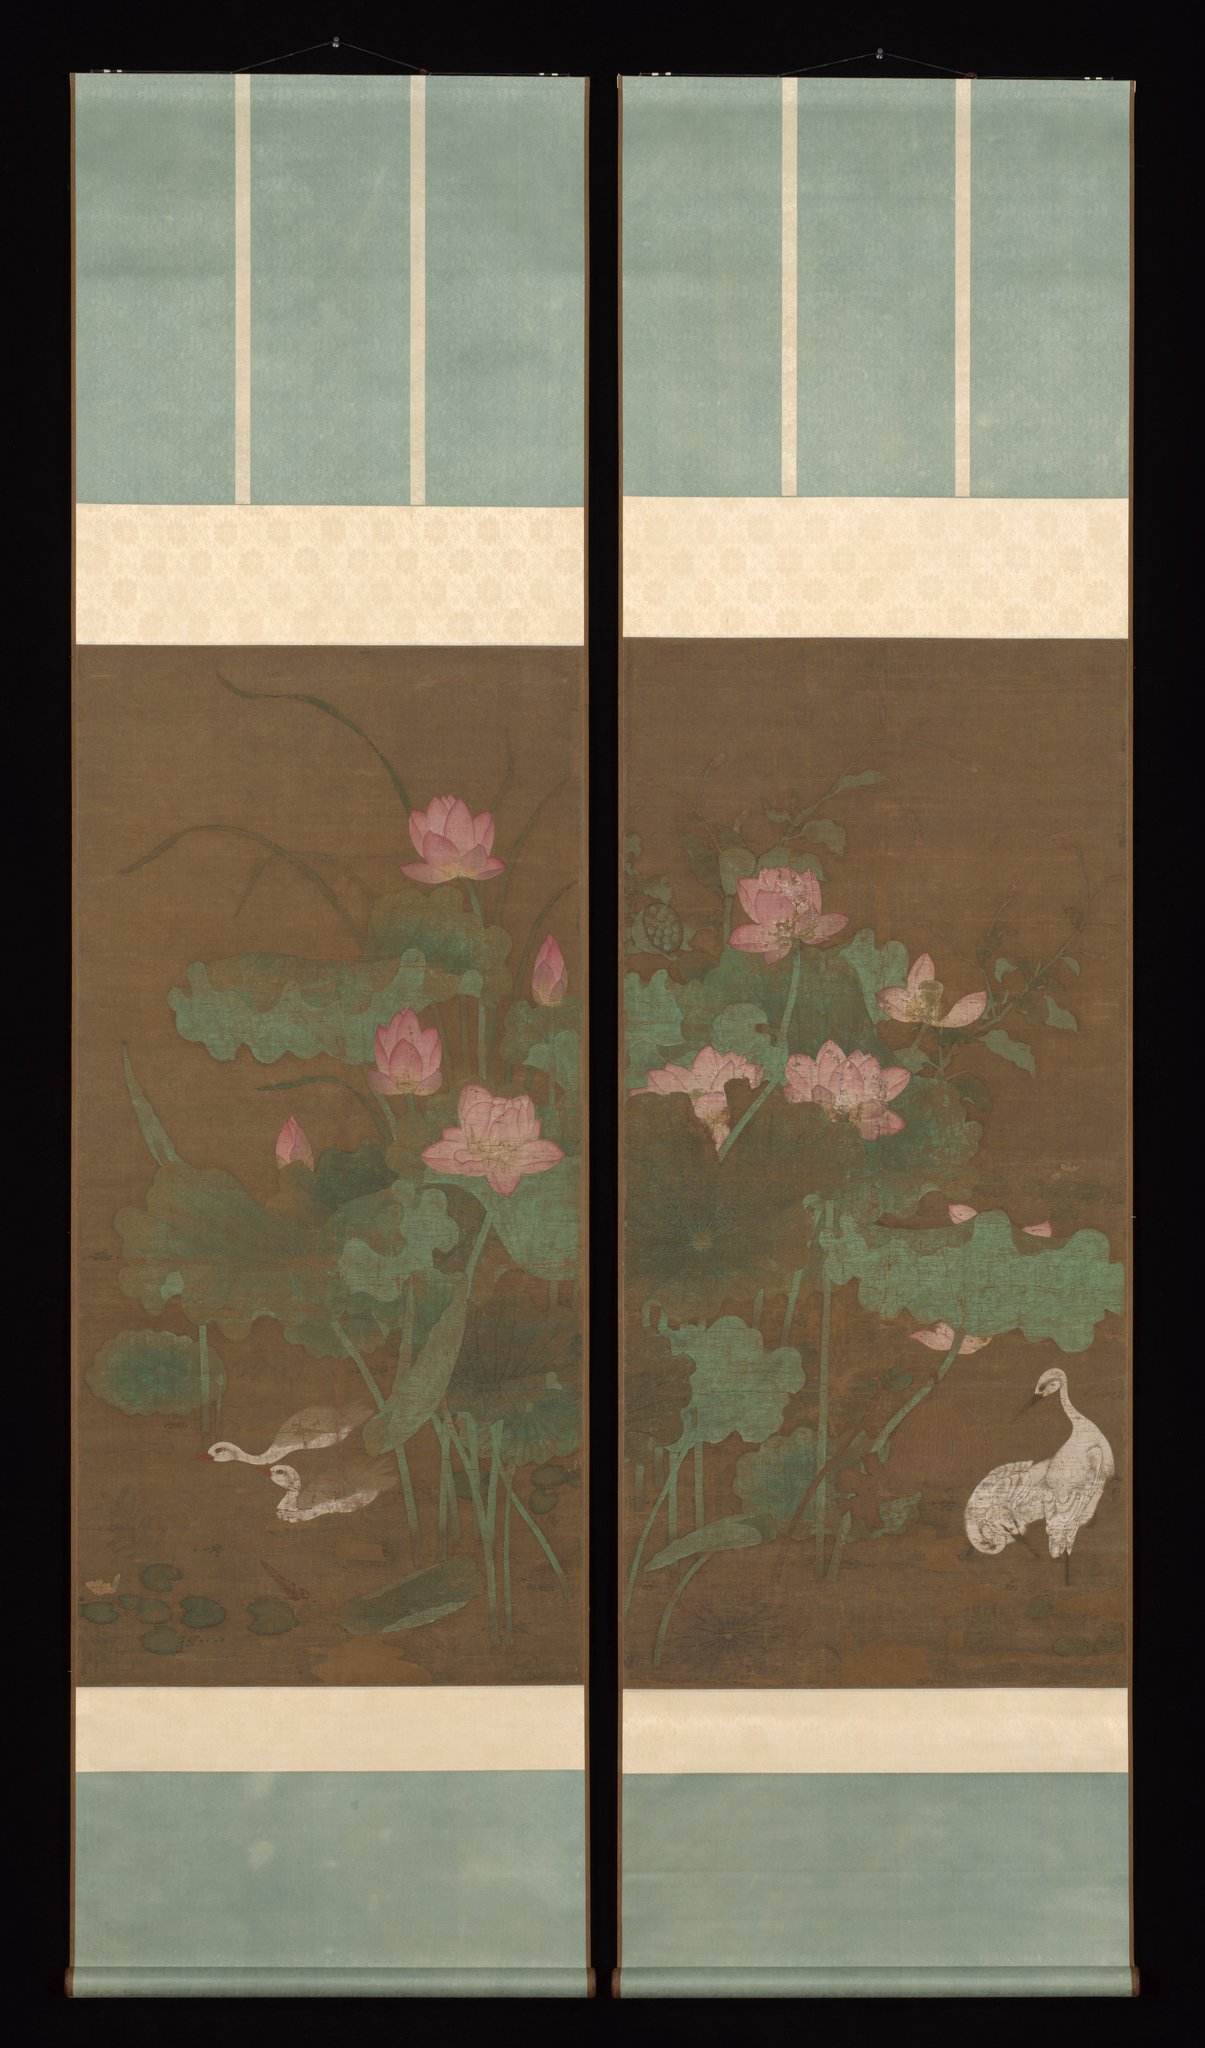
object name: hanging scroll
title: Lotus and waterbirds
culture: chinese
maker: unidentified artist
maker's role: artist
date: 1300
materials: ink, silk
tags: ducks,lotuses